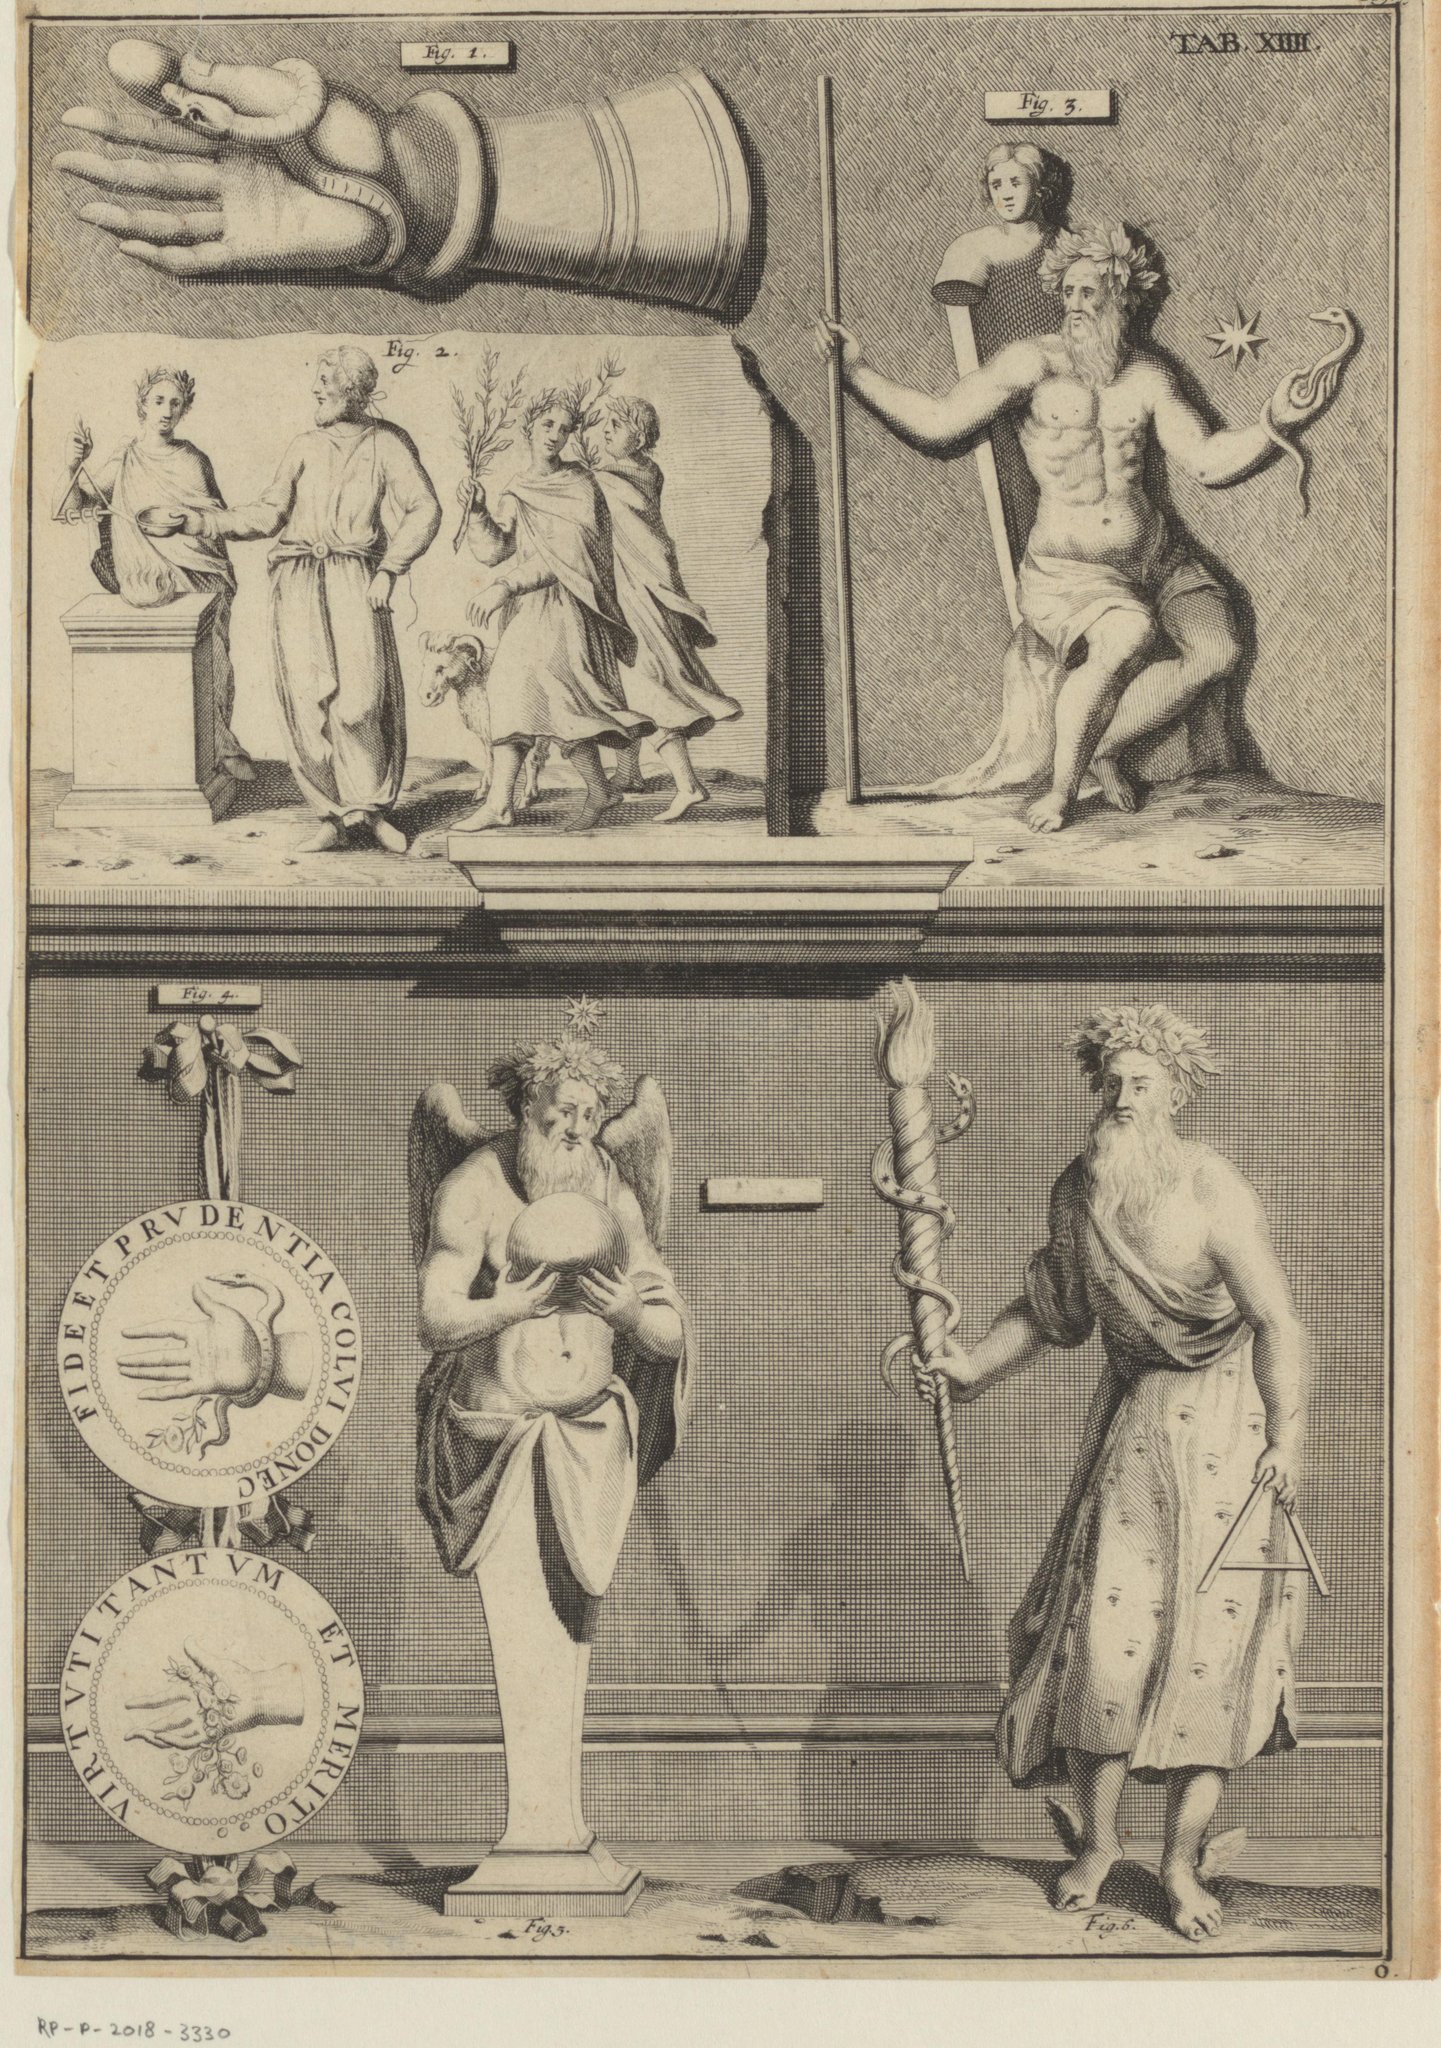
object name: book illustration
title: Compositie met verschillende beelden en figuren bij een Romeins ritueel met slangen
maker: Anonymous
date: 1700-1799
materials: paper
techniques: engraving, etching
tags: snakes, sculpture, sacrifice ~ roman religion, roman religion (including etruscan religion)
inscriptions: collector's mark: Lugt 2228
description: Prent uit een onbekend boek met objecten, kunstwerken en figuren uit de Romeinse geschiedenis en religie. Dit betreft een illustratie bij p. 34.